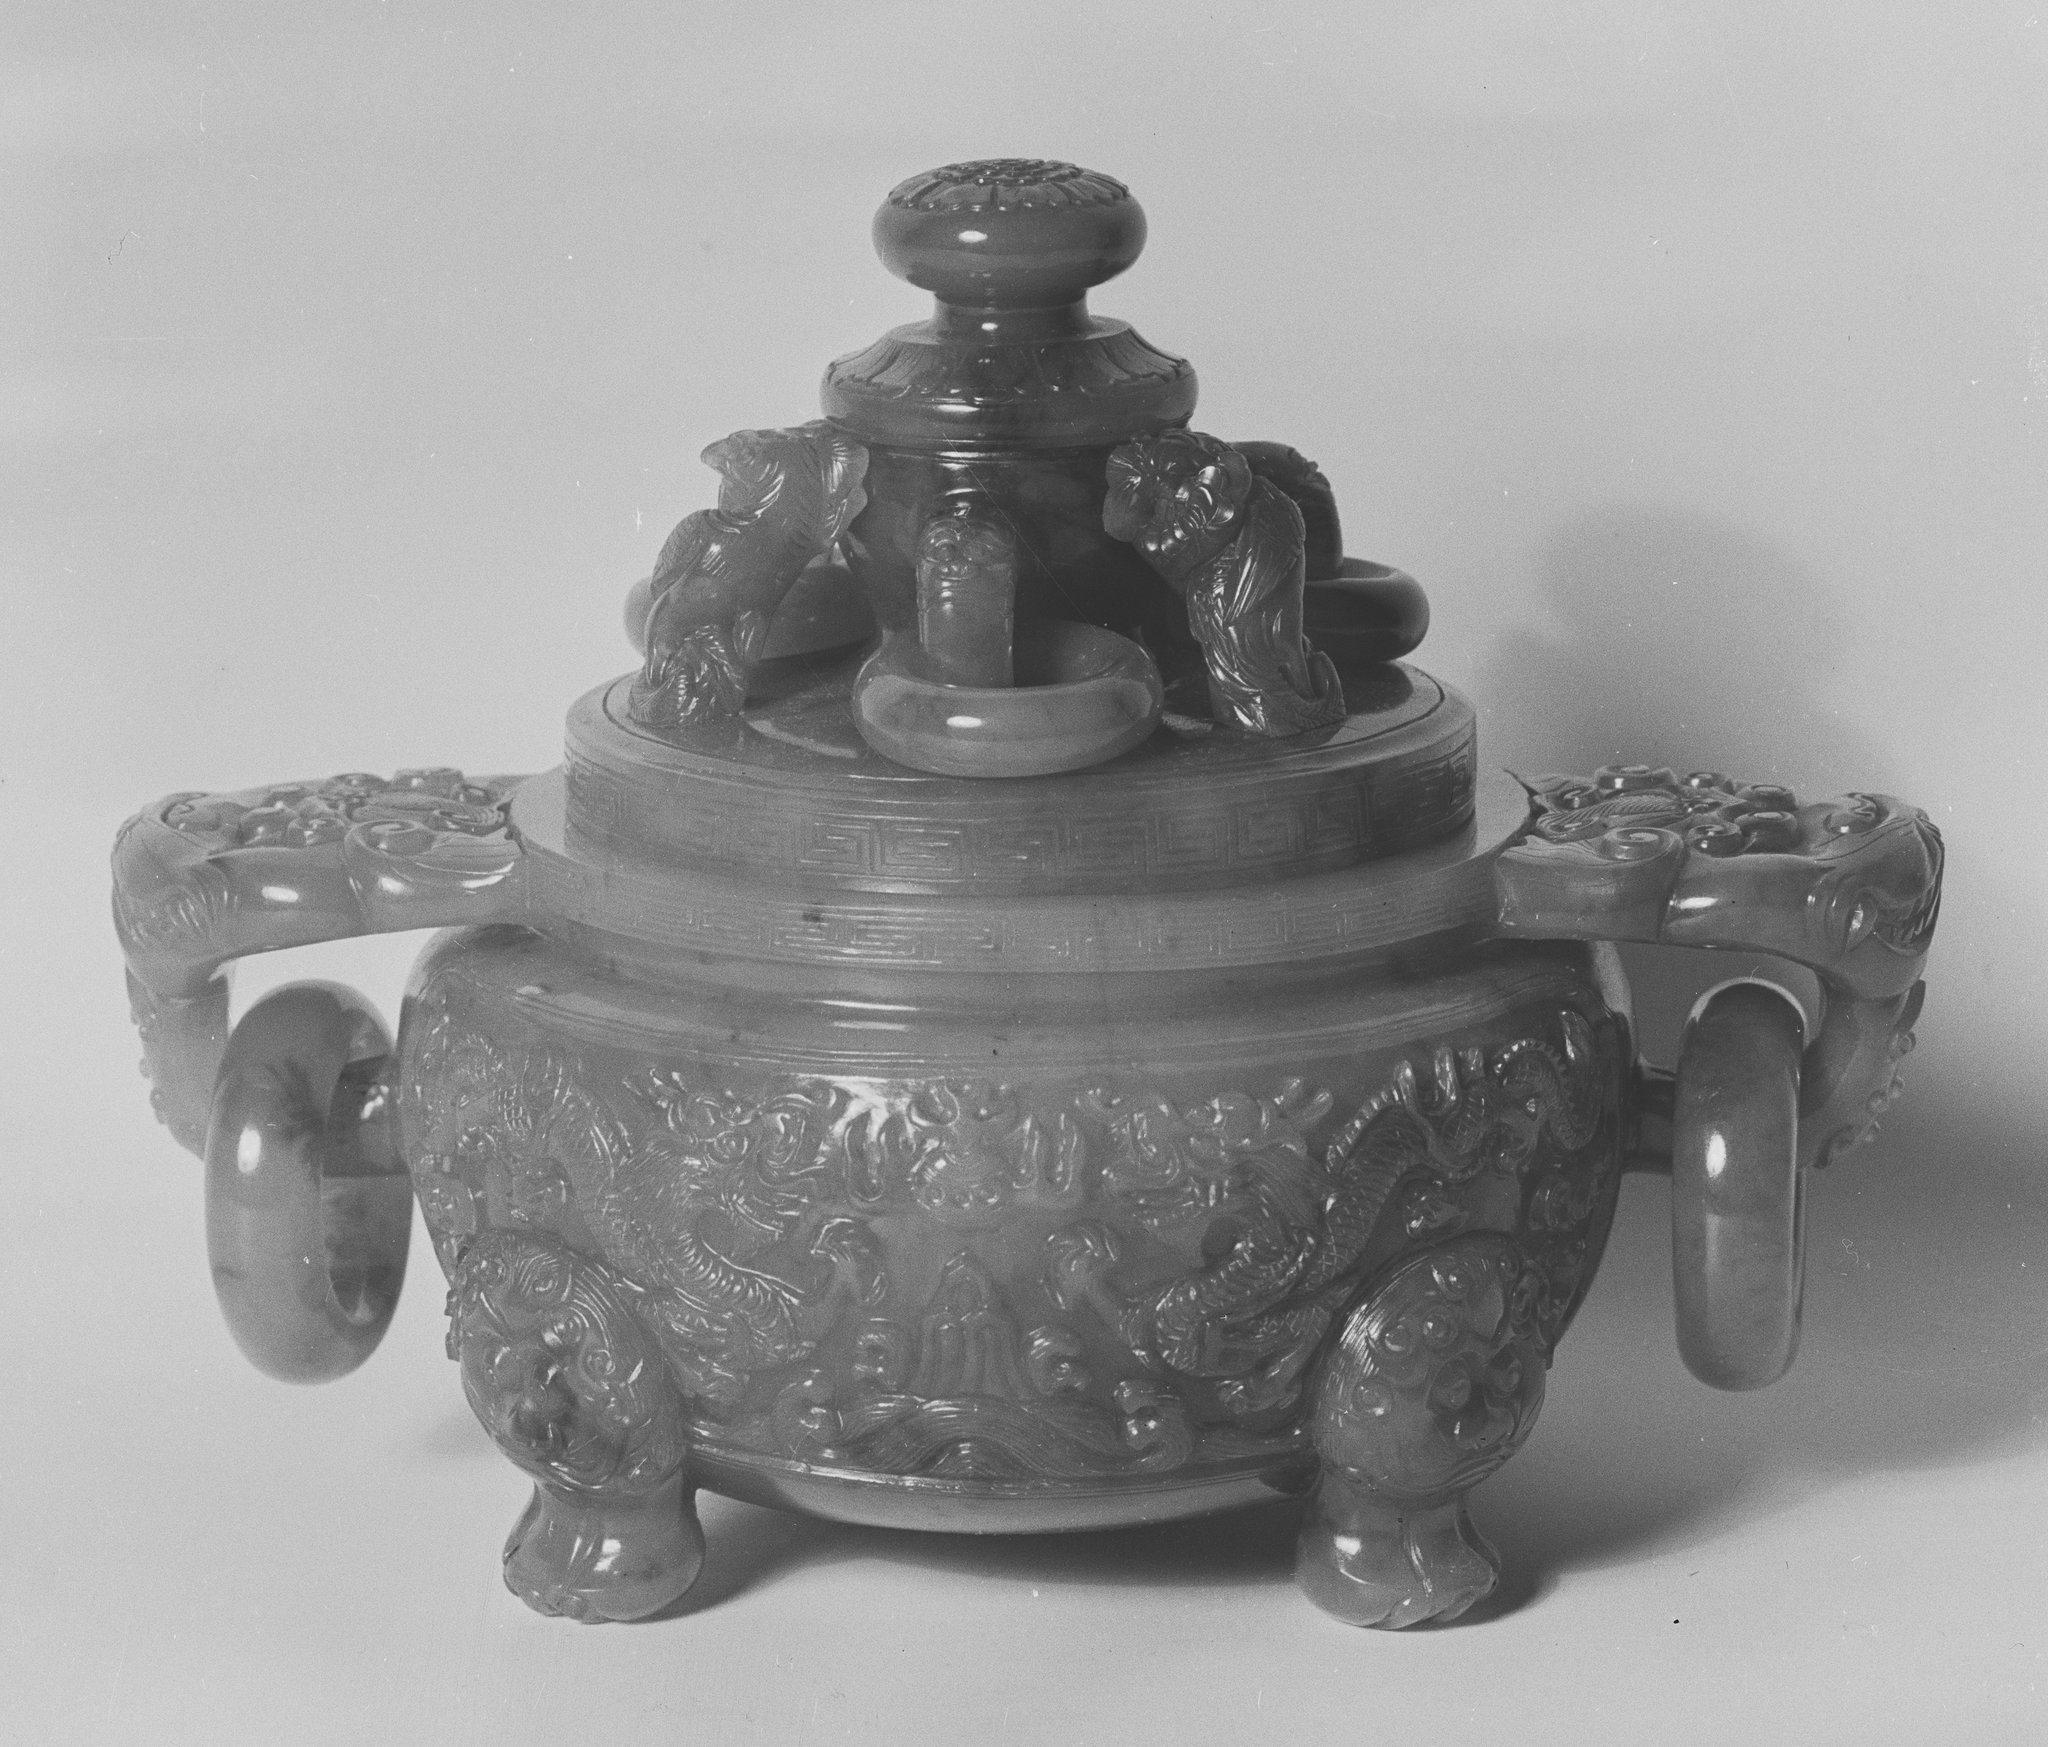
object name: bowl with cover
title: Tripod Bowl with Cover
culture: chinese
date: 1736-1795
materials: jade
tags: dragons